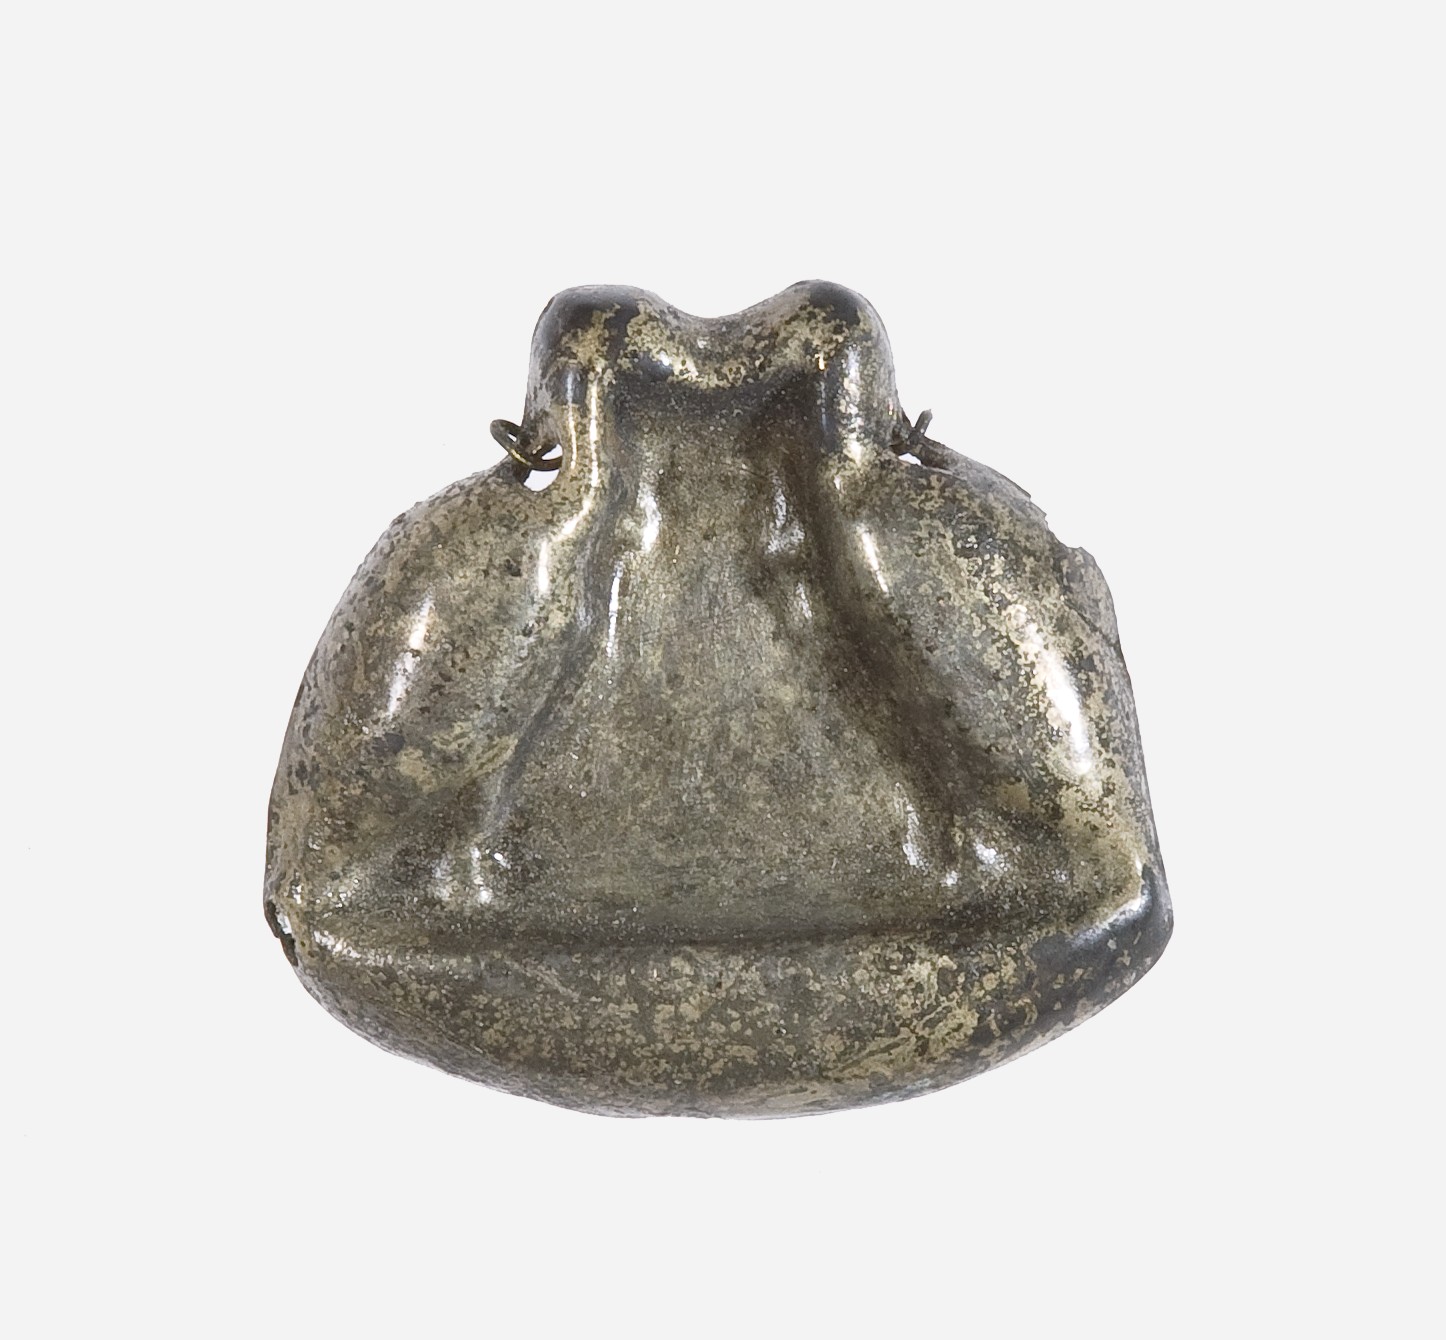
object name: amulet, bird, neb basket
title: Amulet of Two Birds on a Neb-Basket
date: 1850-1775 BCE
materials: silver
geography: egypt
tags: birds